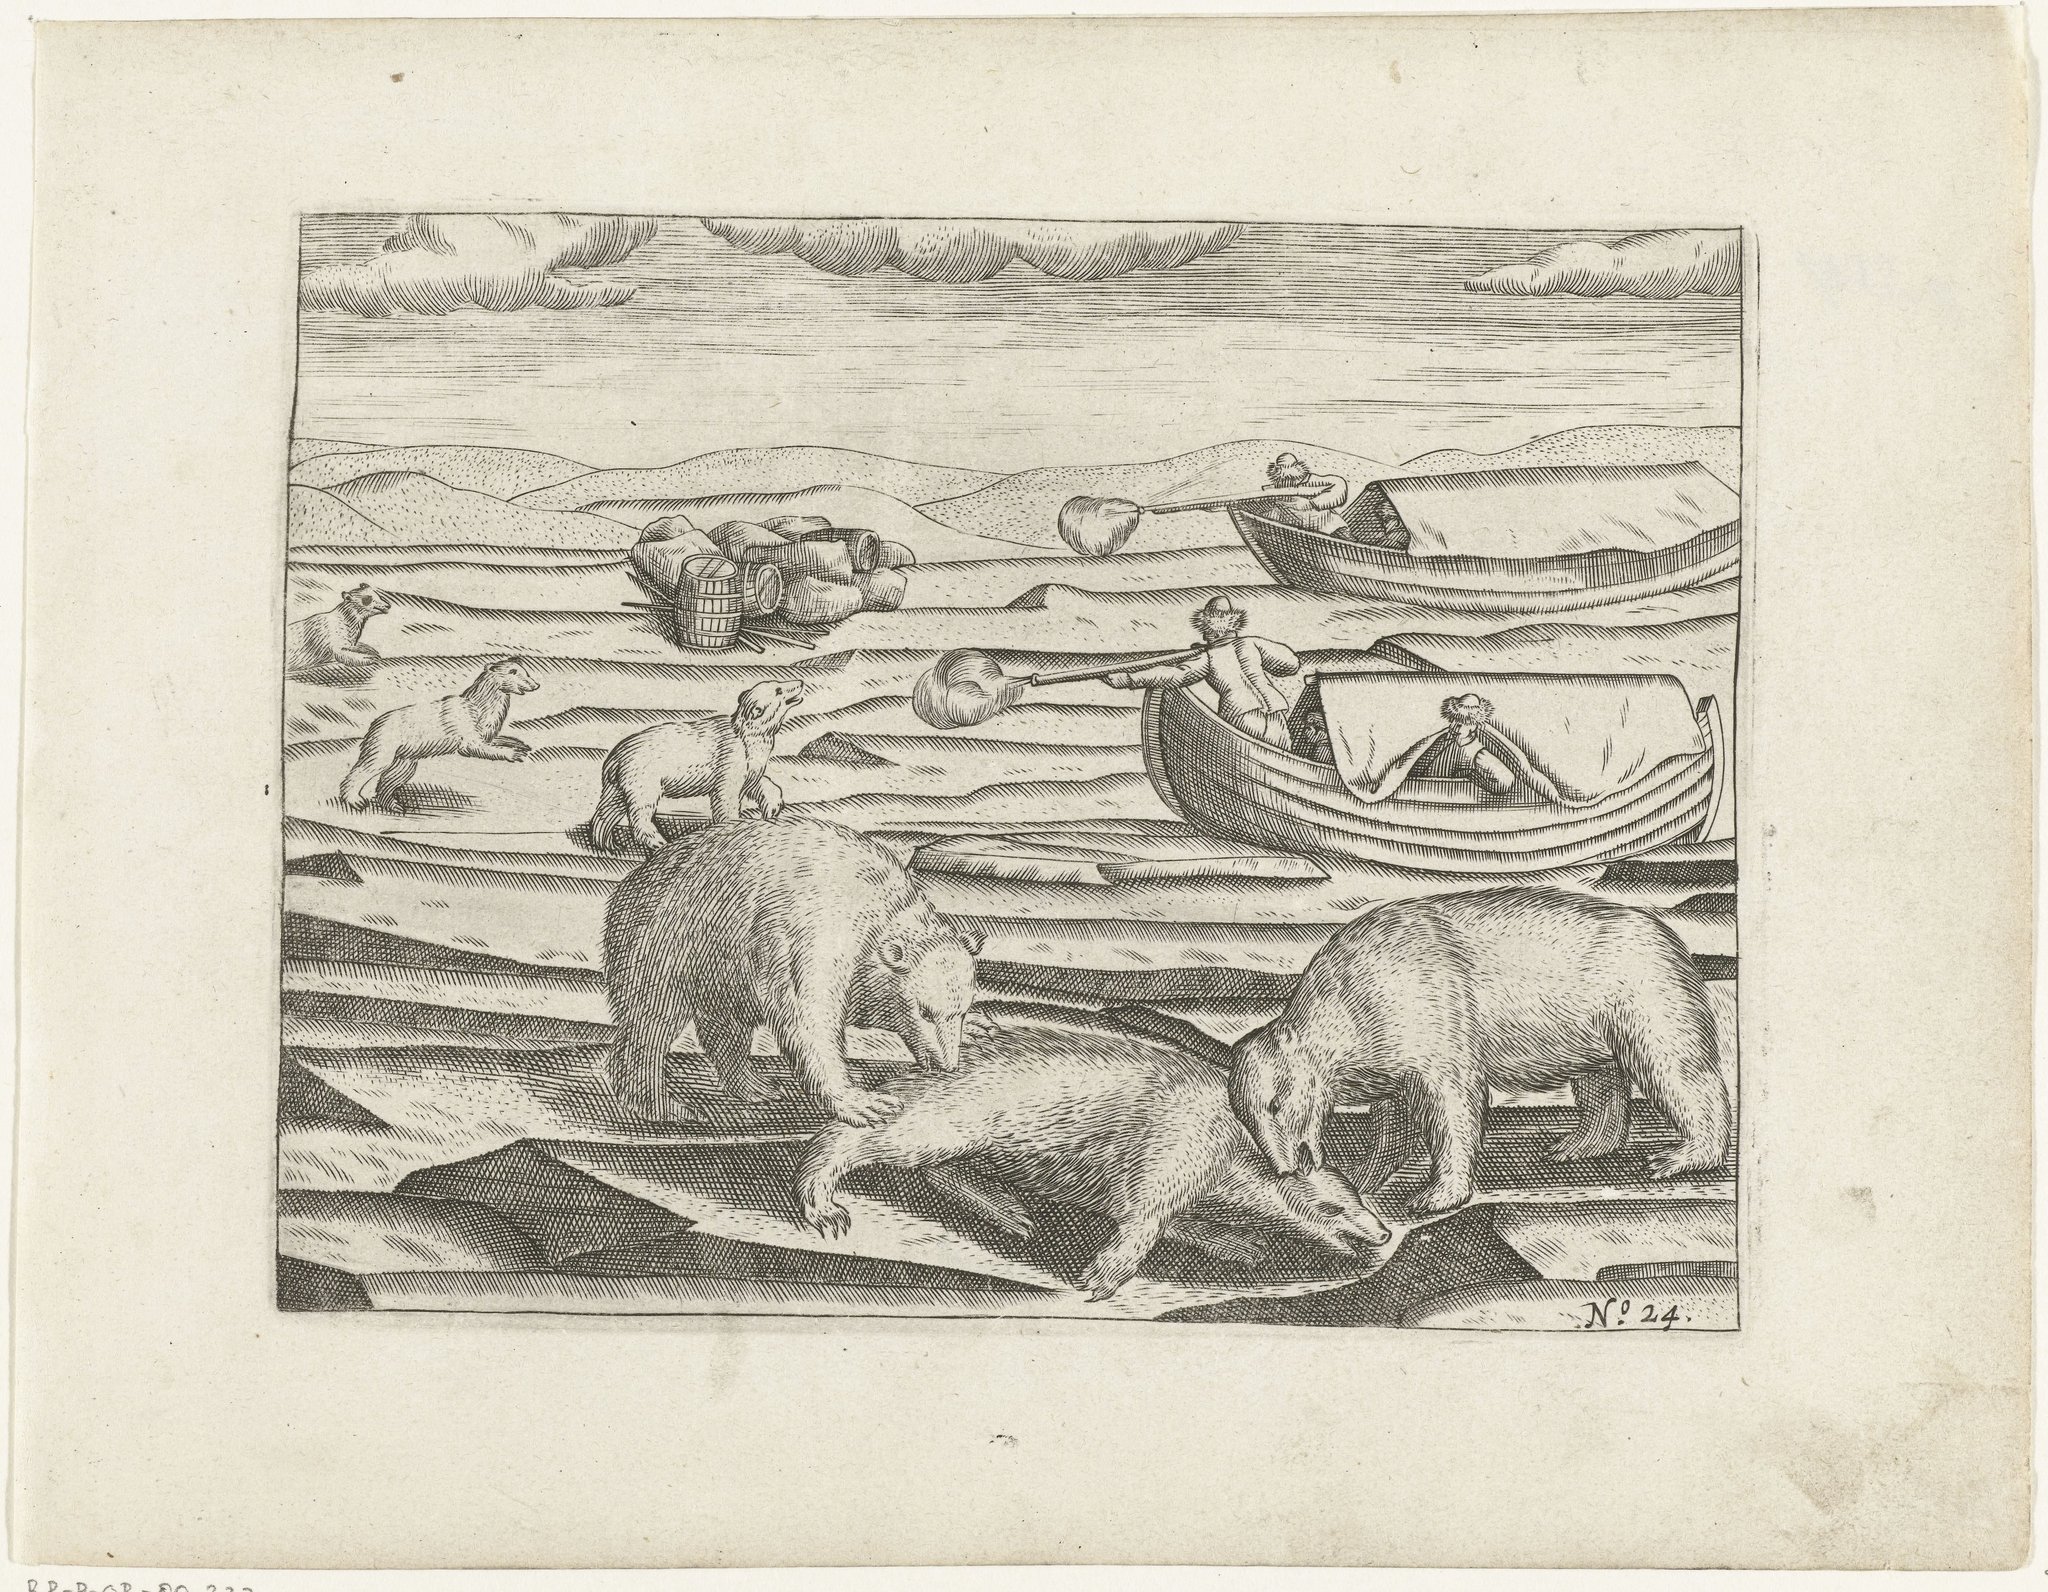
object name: print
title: Aanval door drie ijsberen op de sloepen, 1597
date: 1615-1617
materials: paper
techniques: engraving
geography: northern netherlands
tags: willem barendsz., jacob van heemskerck, beasts of prey, predatory animals: polar bear, landscapes in polar regions, exploration, expedition, voyage of discovery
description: Gebruikt als illustratie eerst in: G. de Veer, De waerachtige beschrijvinge vande drie seylagien, drie jaren achter mal-kanderen deur de Hollandtsche ende Zeelandtsche Schepen, by noorden Noorweghen, Moscovien ende tartarien nae de Coninckrijcken van Catthay ende China ghedaene, [Michiel Colijn, Amsterdam 1617]. Later gebruikt in: Kort verhael van d'eerste Schipvaerd der Hollandsche ende Zeeusche Schepen by noorden Noorwegen, Moscovien ende Tartarien om, nae de Coningrijcken van Cathay ende China, getogen uyt het Journael van Gerrit de Veer. Opgenomen in: I. Commelin, Begin ende voortgangh, van de Vereenighde Nederlantsche Geoctroyeerde Oost-Indische Compagnie, J. Janssonius, Amsterdam 1646. Genummerd: No. 24.